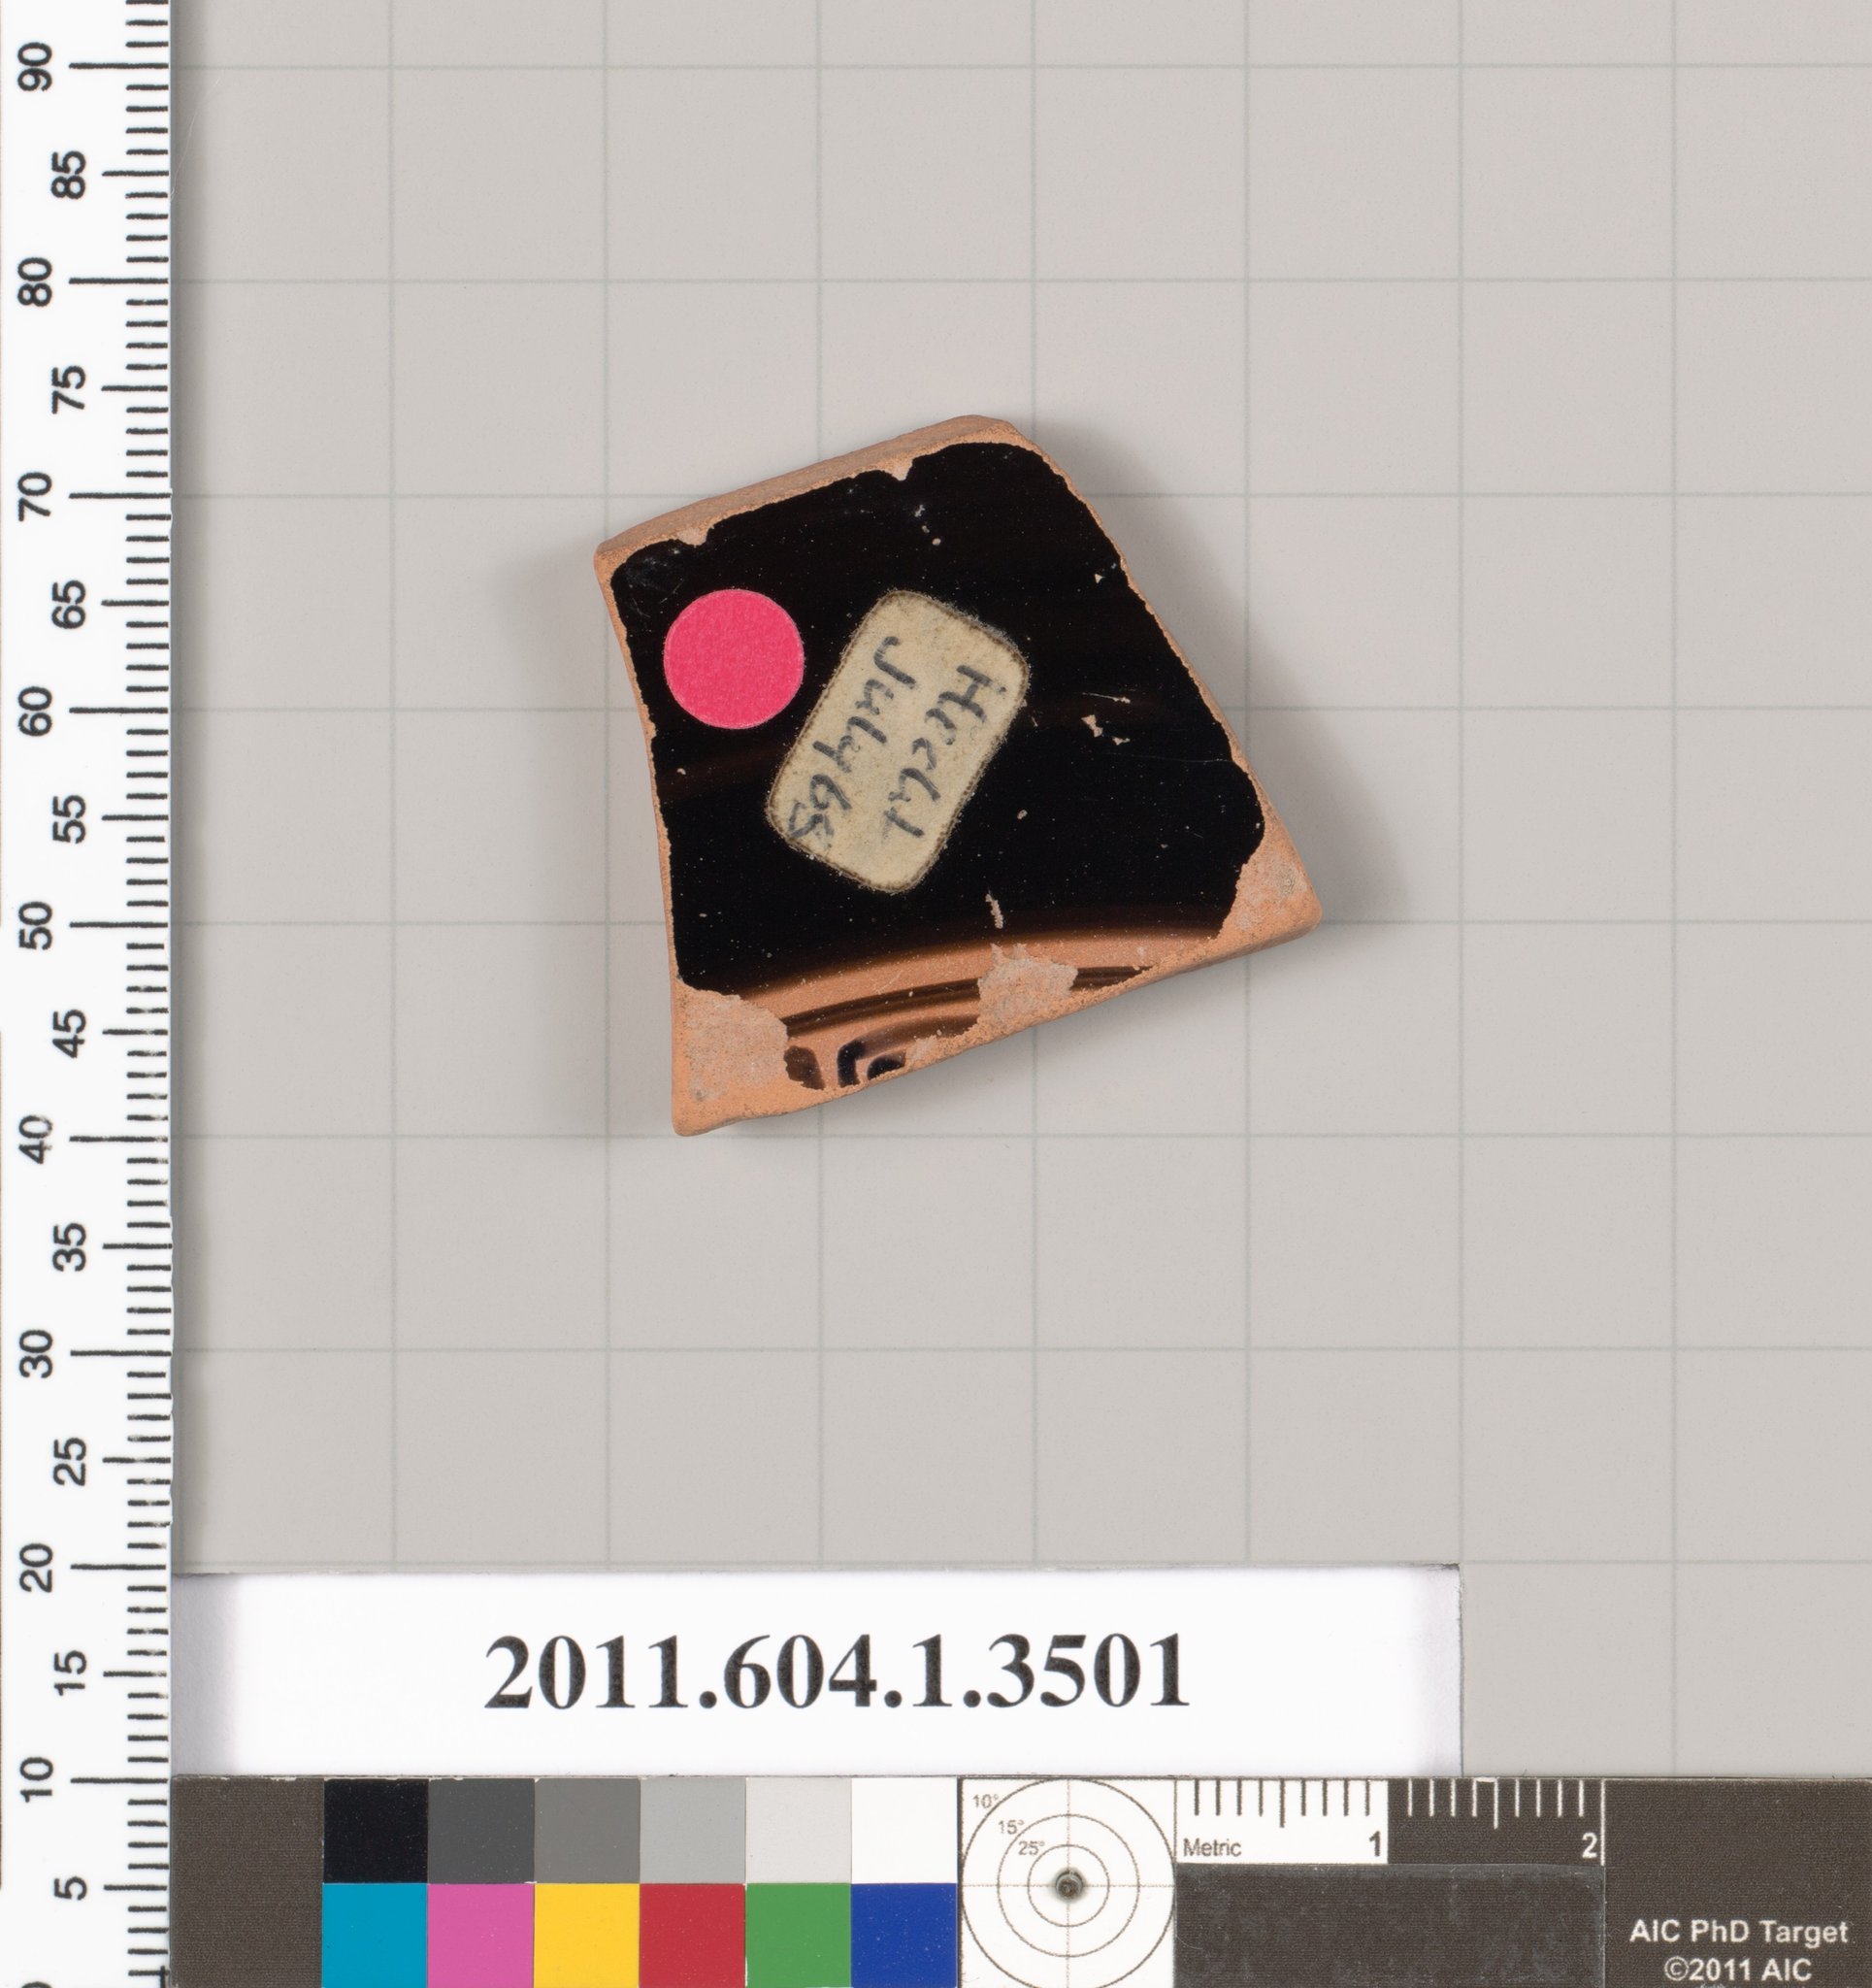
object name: kylix fragment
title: Terracotta fragment of a kylix (drinking cup)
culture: greek, attic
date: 475-451 BCE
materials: terracotta